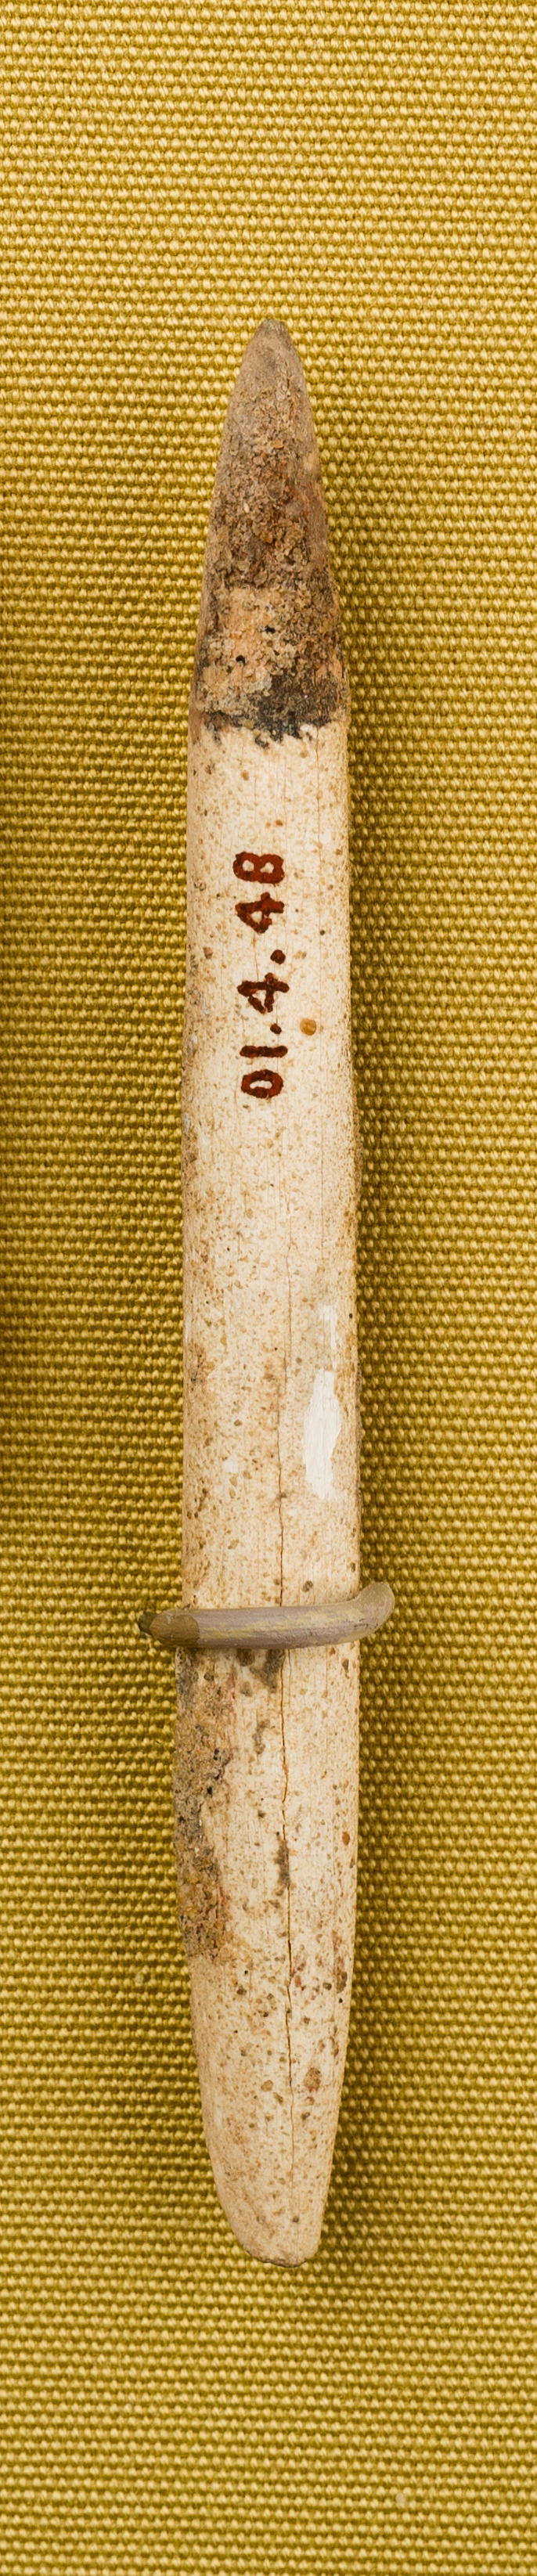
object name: arrowhead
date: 3100-2900 BCE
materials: ivory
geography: egypt